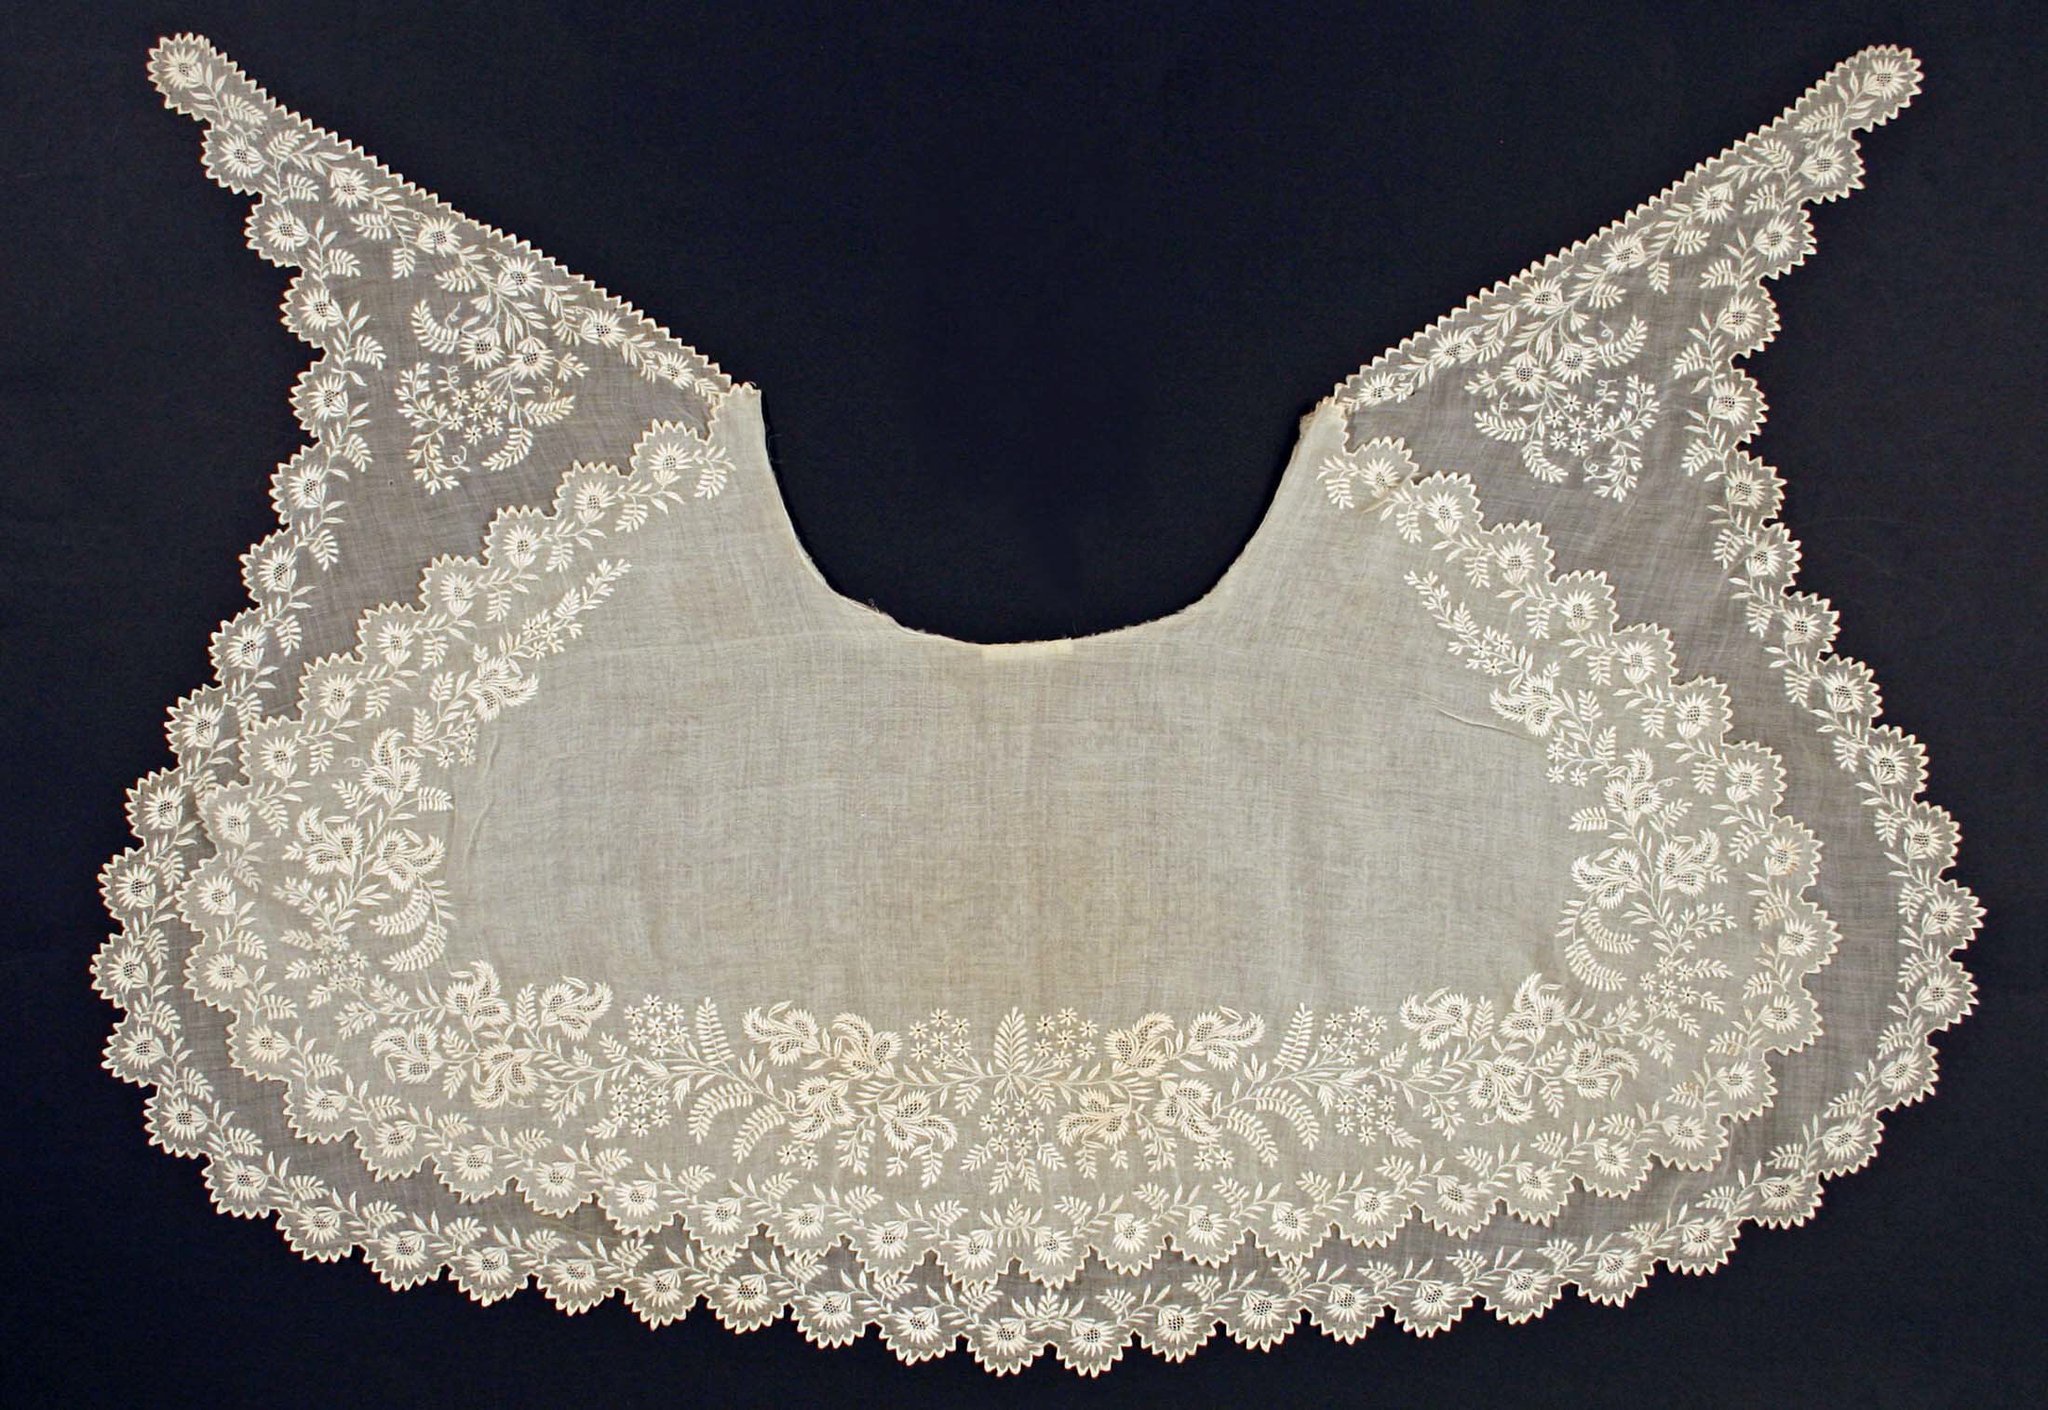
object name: collar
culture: american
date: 1830-1839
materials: cotton